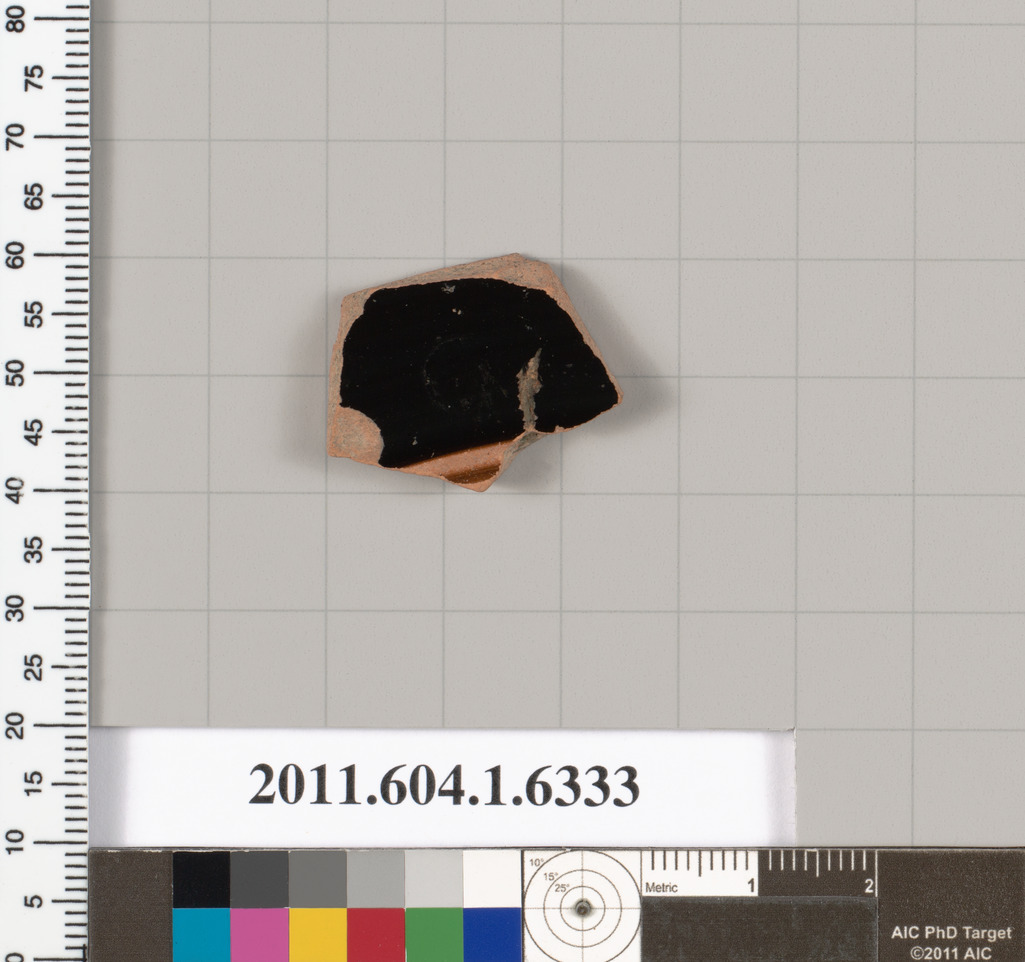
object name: kylix fragment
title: Terracotta fragment of a kylix (drinking cup)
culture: greek, attic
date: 500-480 BCE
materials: terracotta